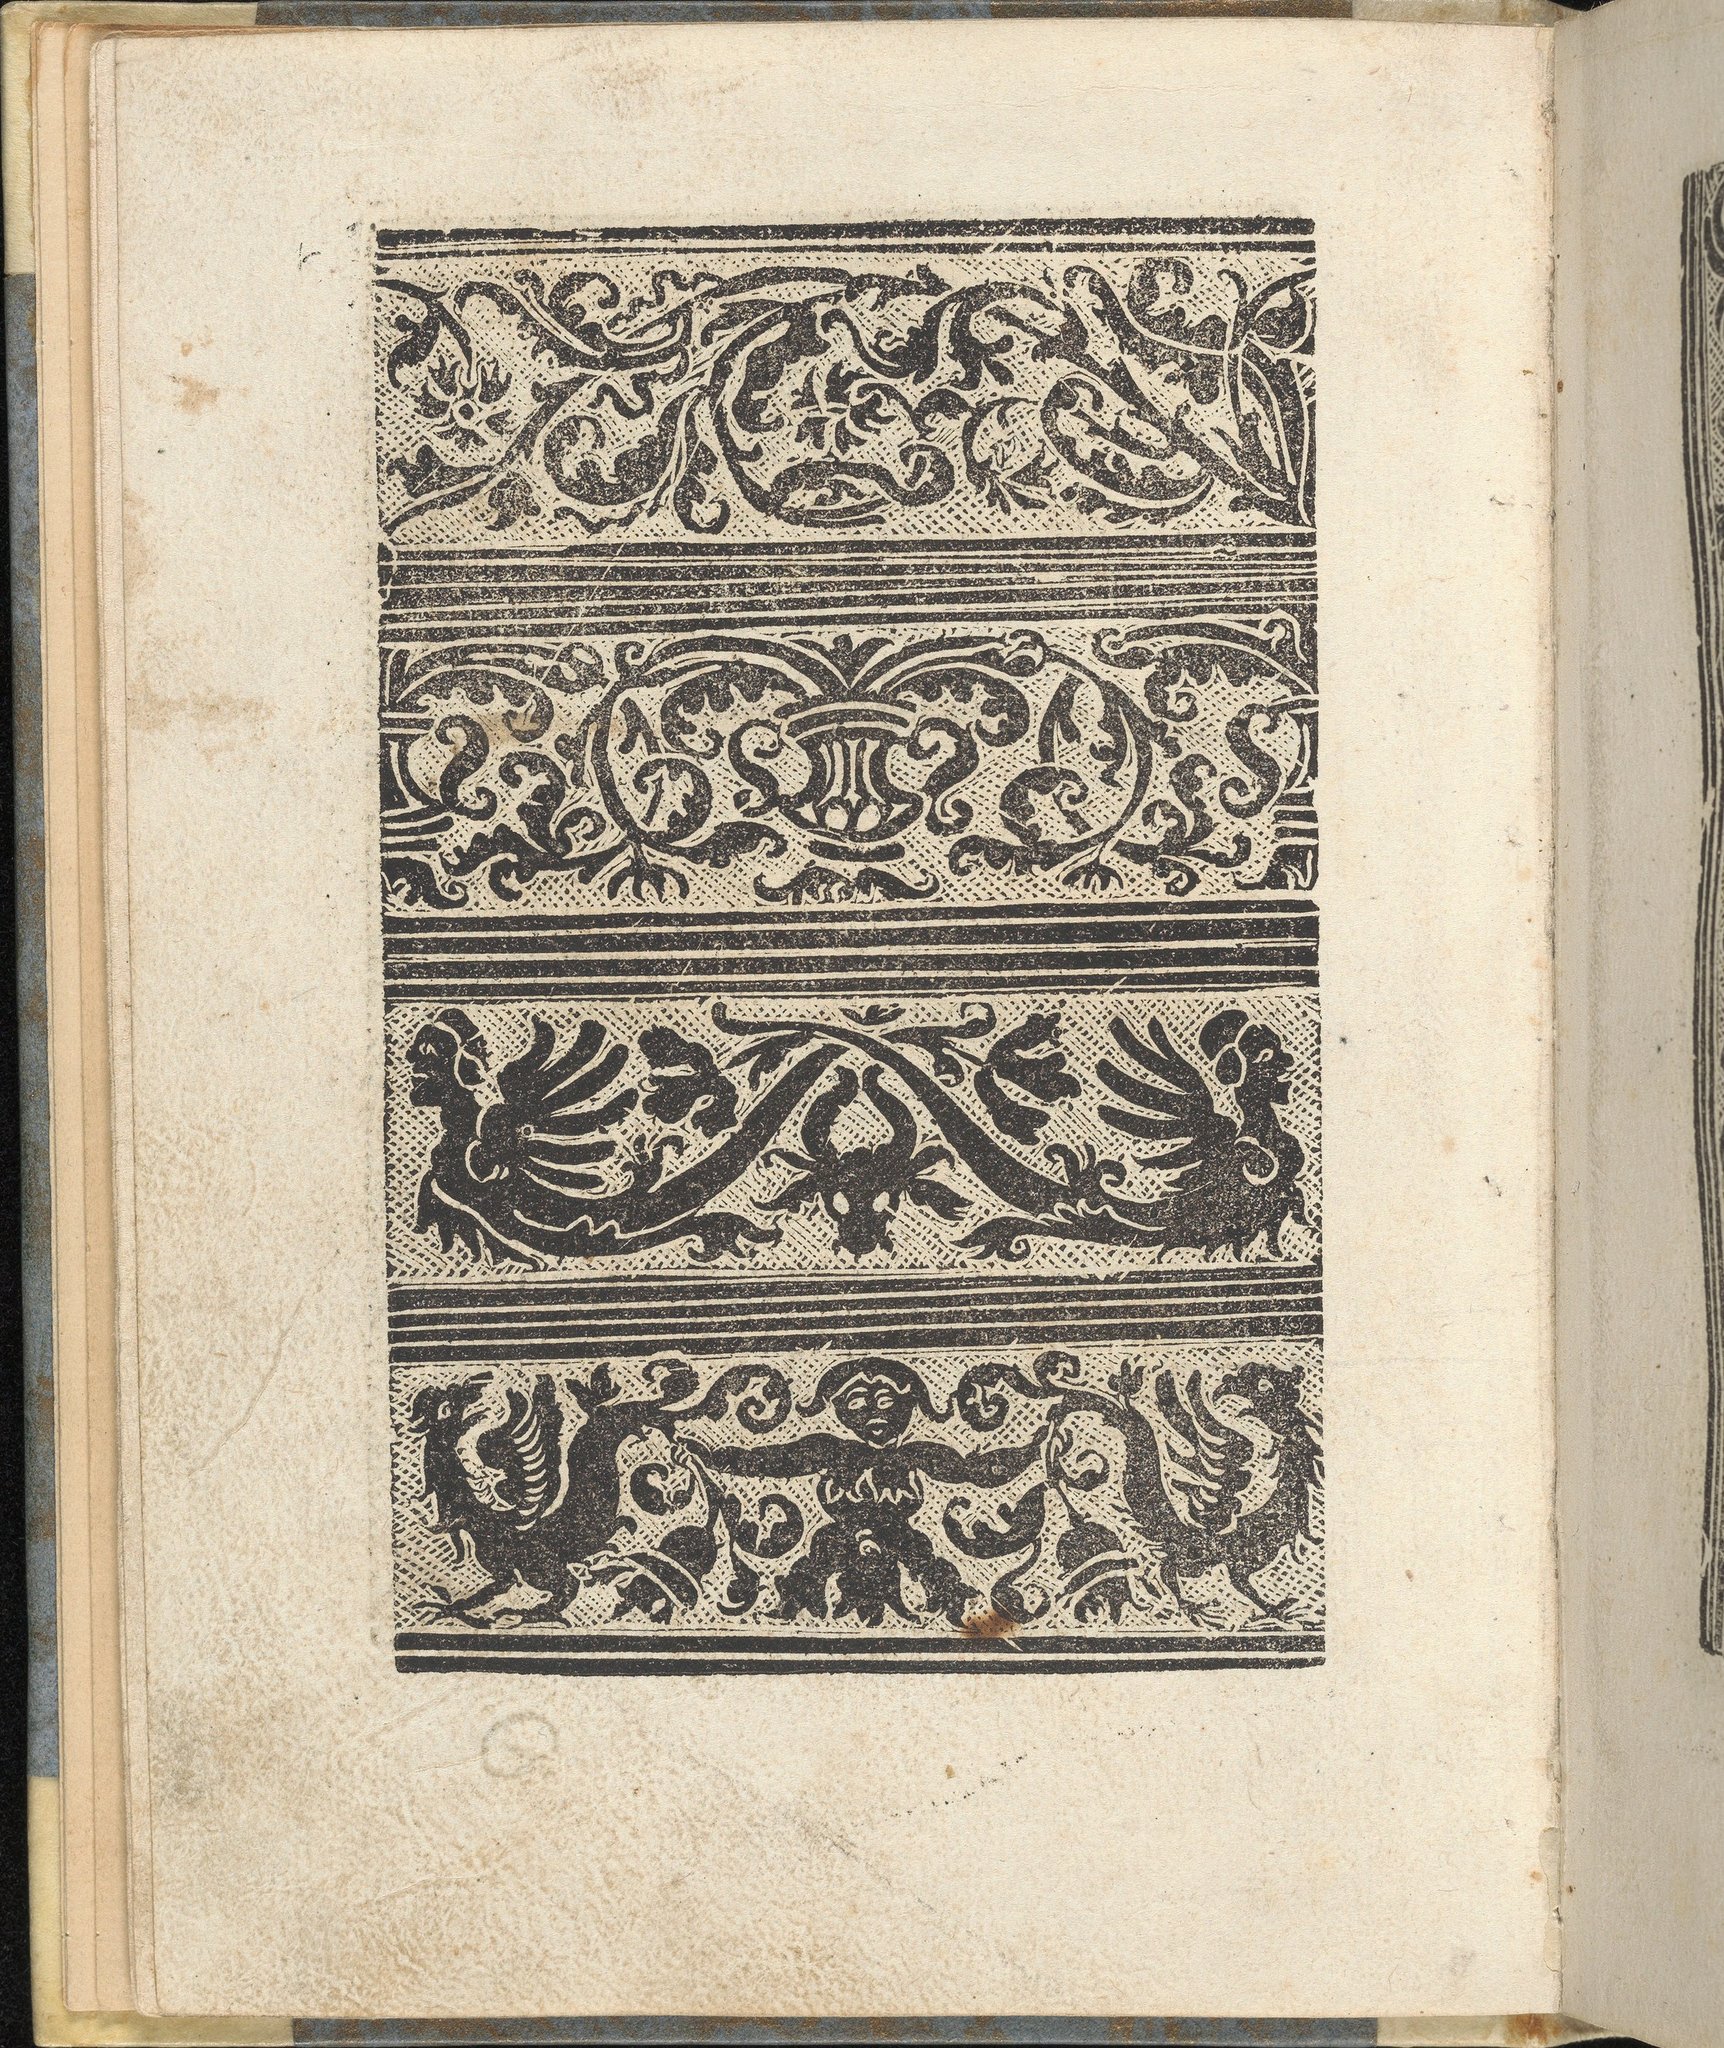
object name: book print ornament architecture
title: Ein ney Furmbüchlein, Page 11, verso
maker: johann schönsperger the younger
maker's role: publisher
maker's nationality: german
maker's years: 1490-1550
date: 1525-1529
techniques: woodcut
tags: ornament